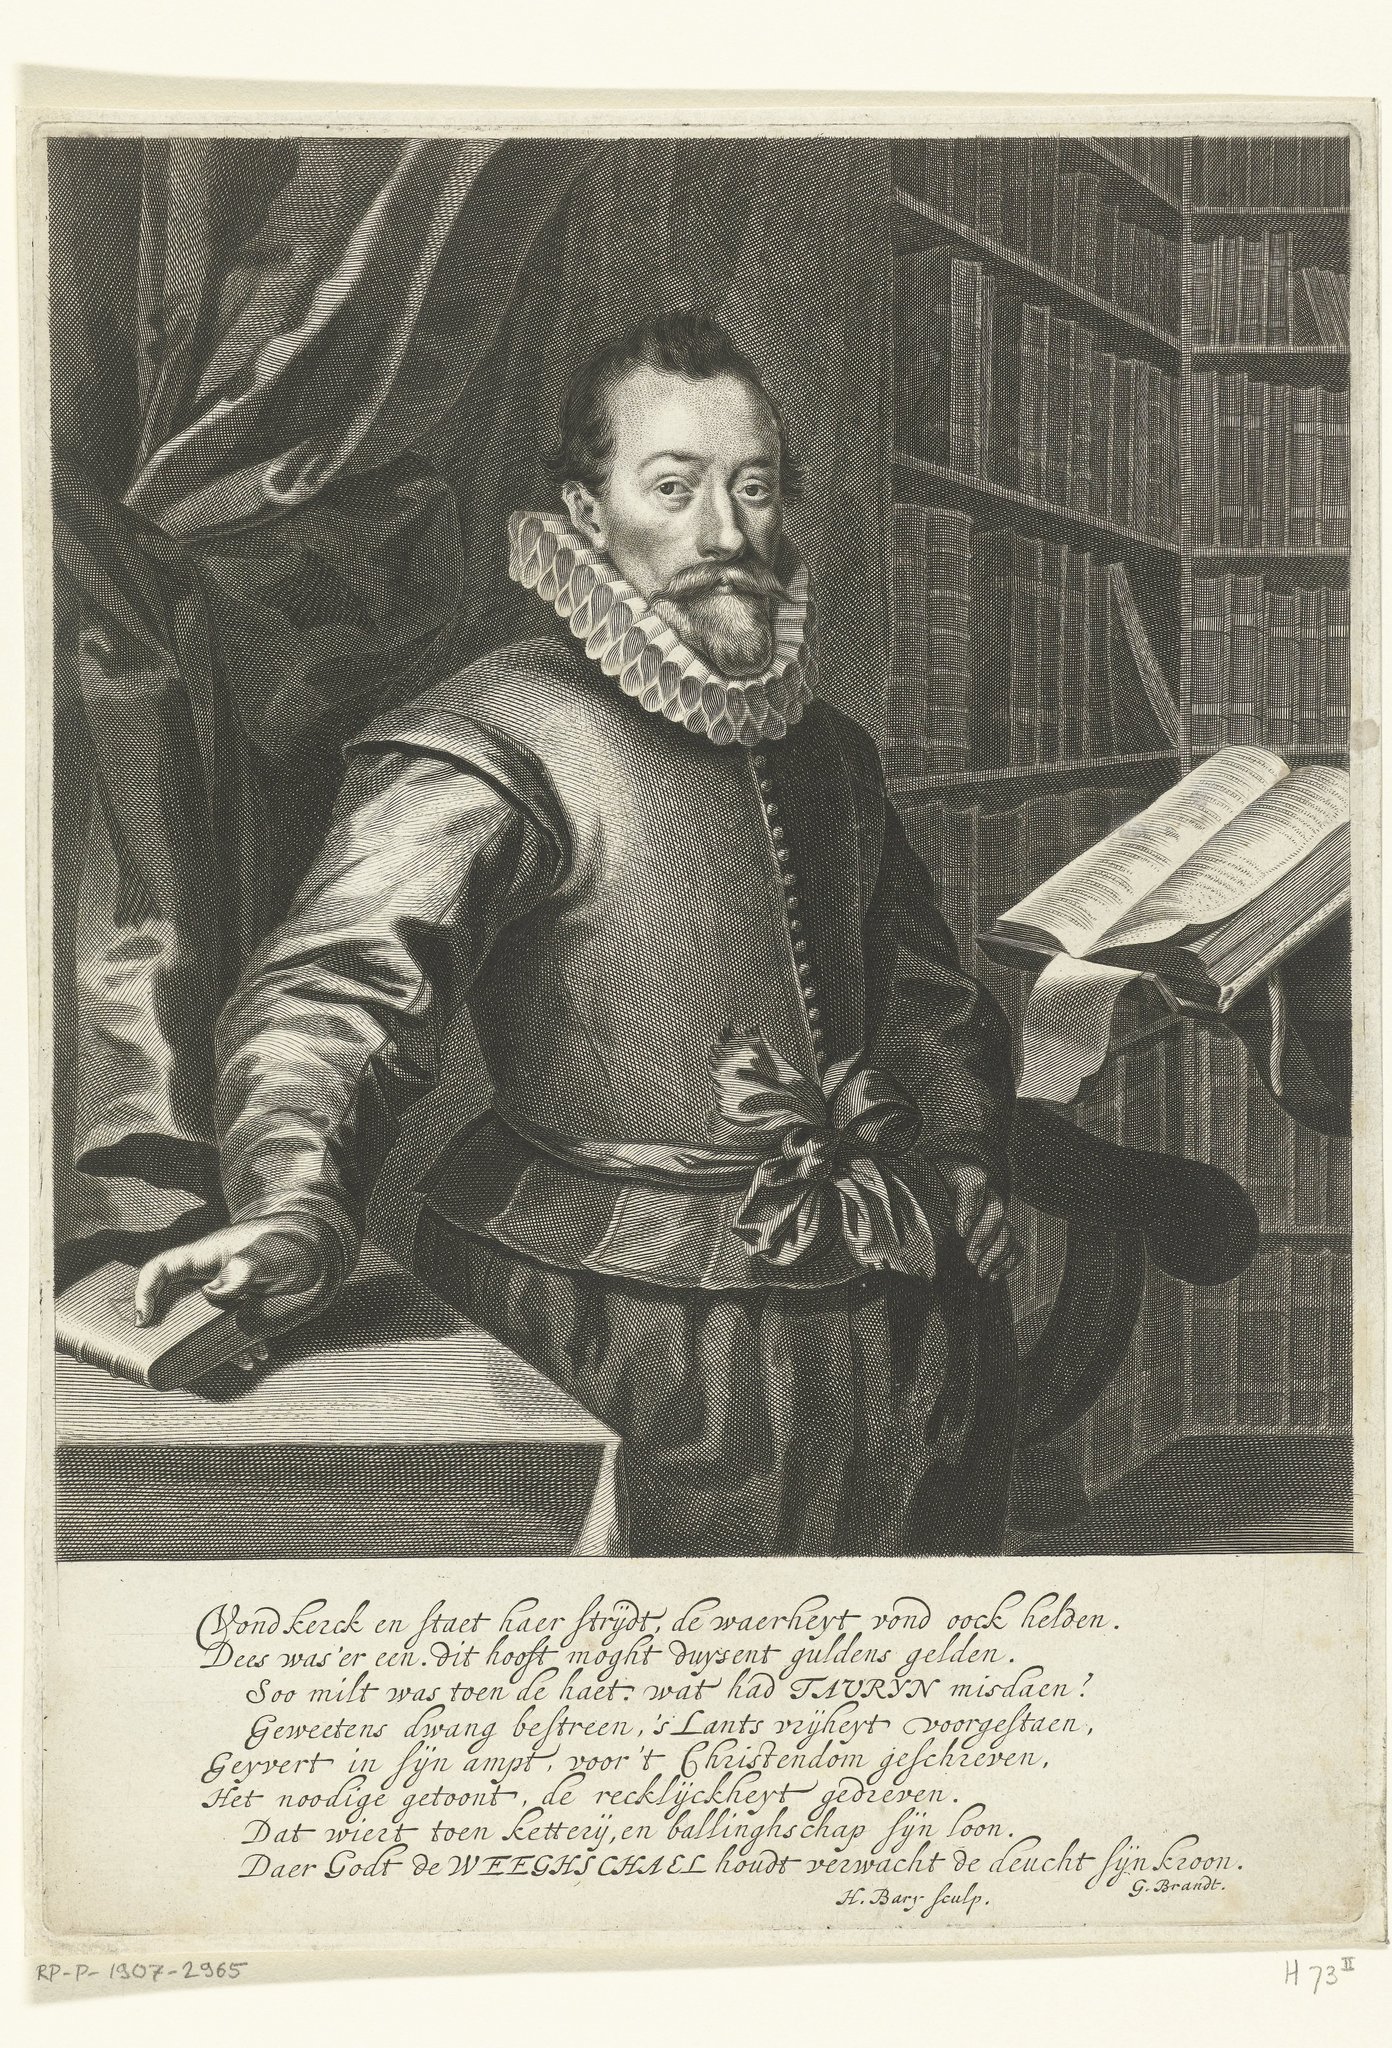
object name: print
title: Portret van Jacobus Taurinus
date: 1657-1707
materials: paper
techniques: engraving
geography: netherlands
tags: antwerp, study; 'studiolo'; library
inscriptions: collector's mark: Lugt 2166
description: Portret van Jacobus Taurinus, staand aan een lessenaar in een bibliotheek. Onder het portret een vers van acht regels in het Nederlands.